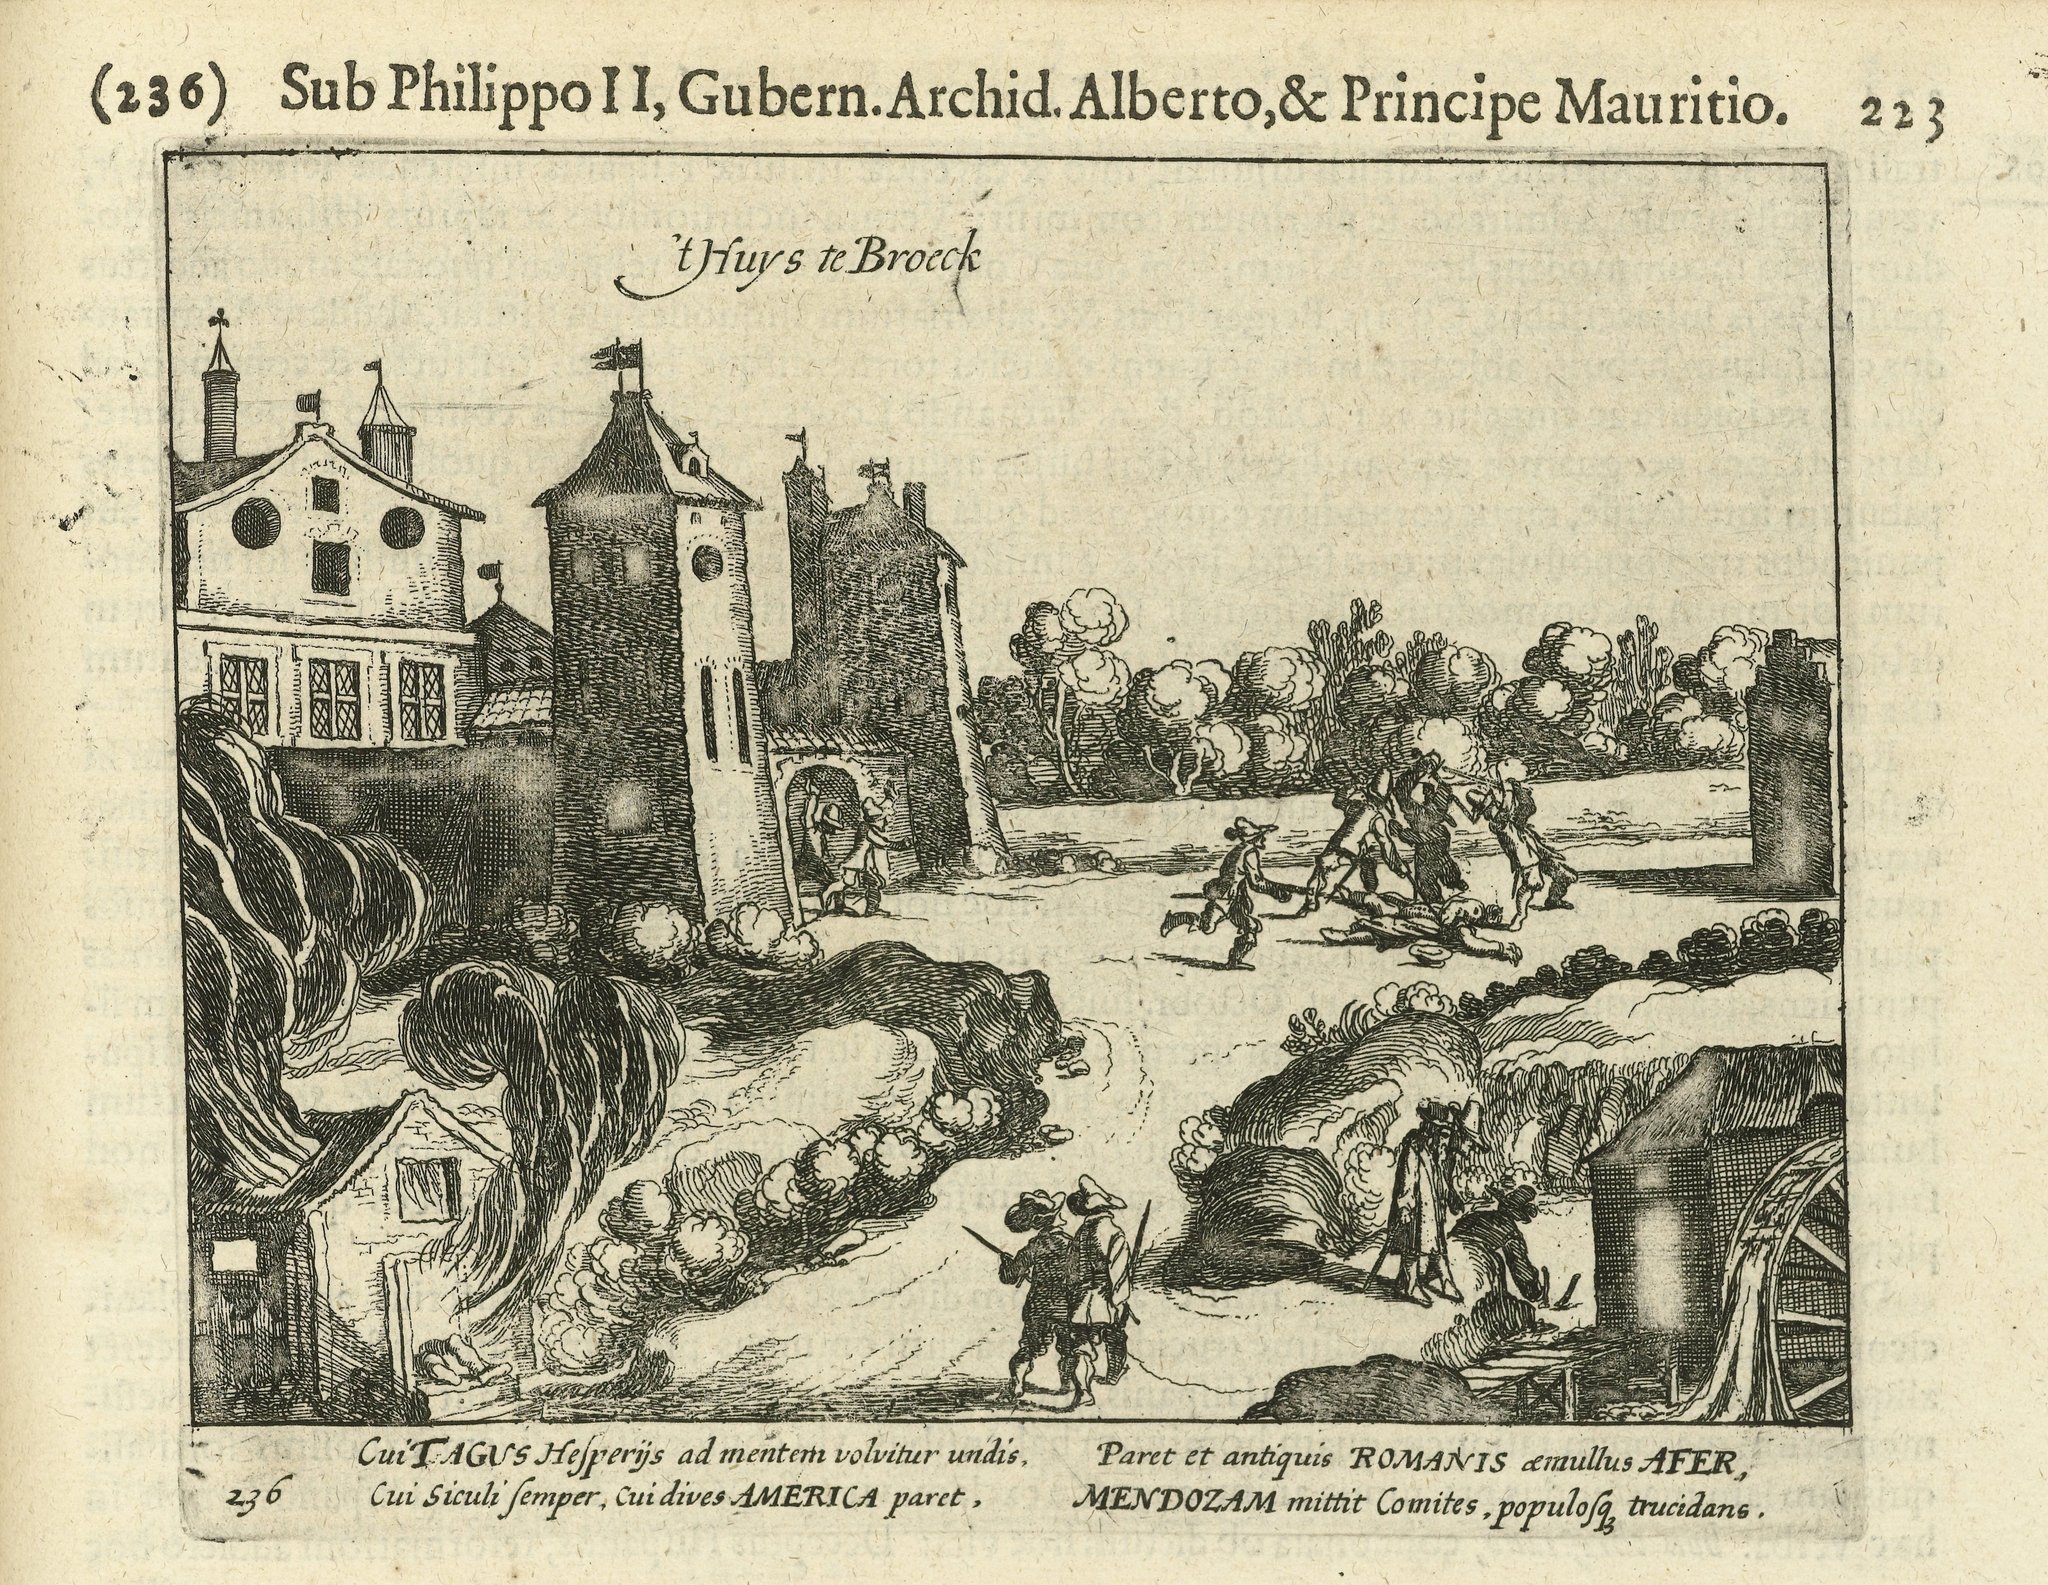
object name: history print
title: Verovering van het kasteel te Broek en de moord op Wirich von Daun, graaf van Falkenstein, 1598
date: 1613-1615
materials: paper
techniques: etching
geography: amsterdam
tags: capture of city (after the siege), violent death, being killed; being mishandled and maltreated; seeking death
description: Verovering van het kasteel te Broek aan de Ruhr en de moord op Wirich von Daun, graaf van Falkenstein, door de Spanjaarden onder Francisco de Mendoza begaan op 11 oktober 1598. Met onderschrift van vier regels in het Latijn. Genummerd 236. Bedrukt op de achterzijde met tekst in het Latijn.